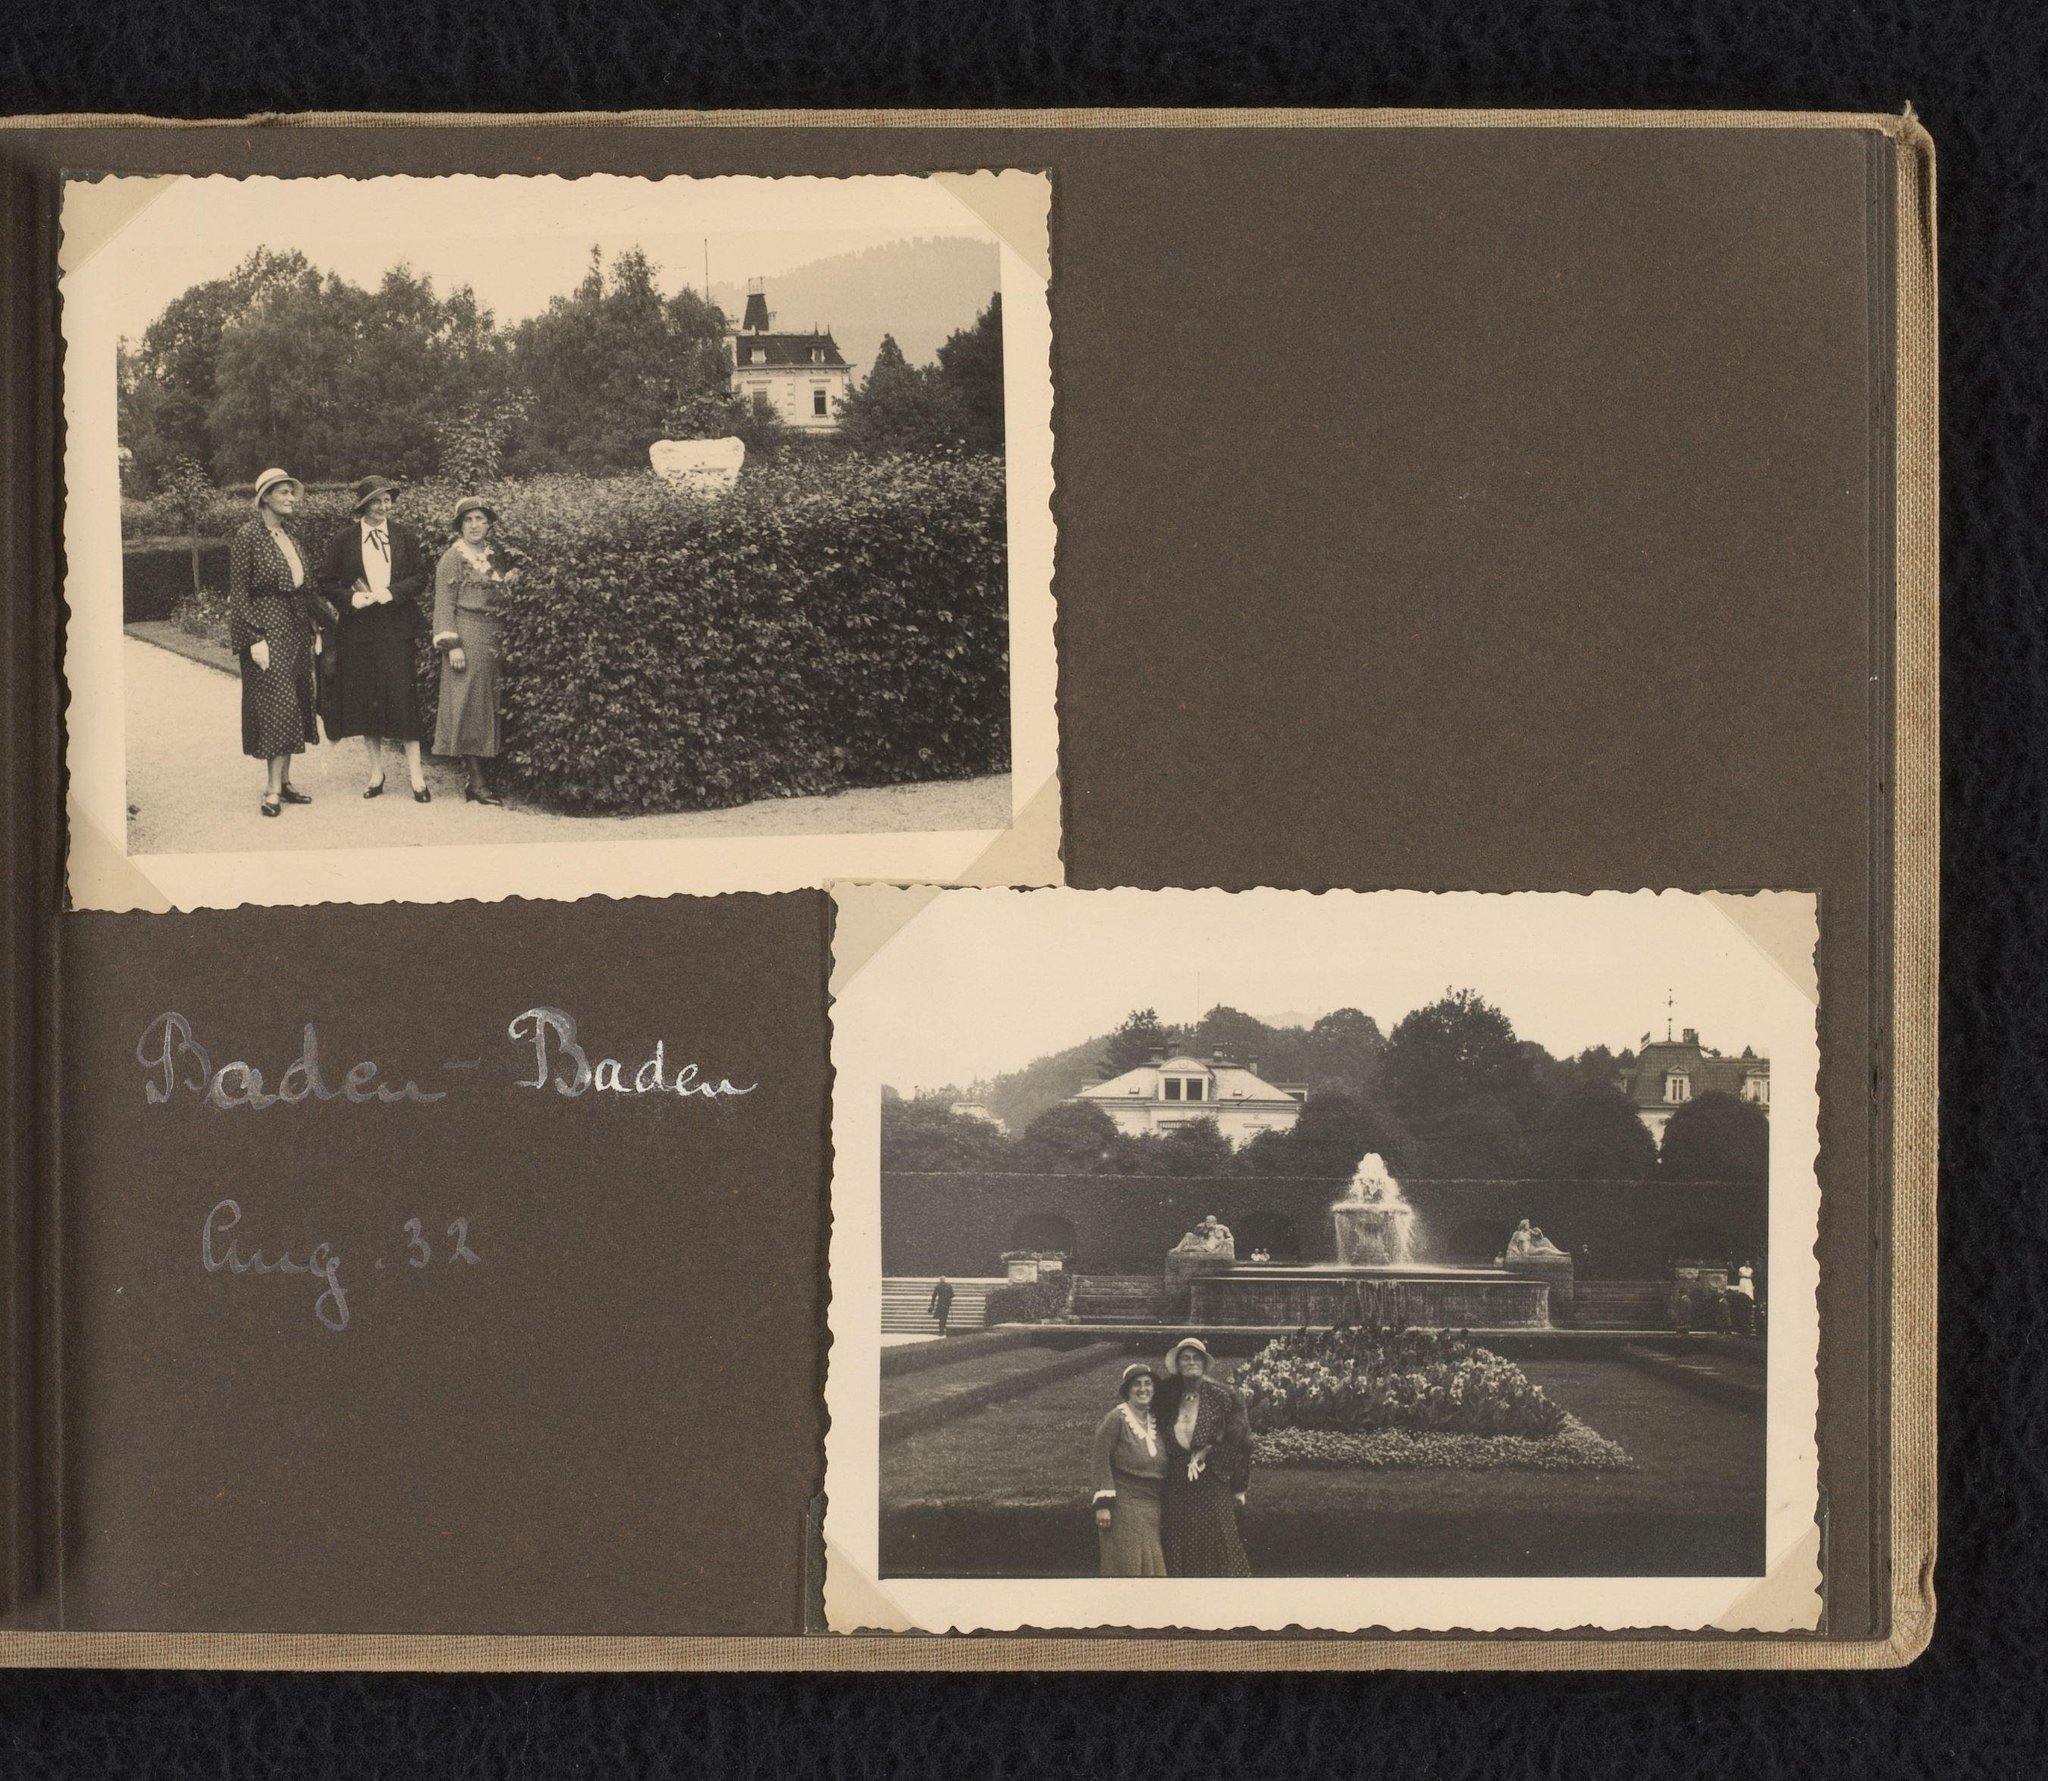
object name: photograph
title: Else Wachenheimer-Moos op vakantie met twee onbekende vrouwen, augustus 1932, Baden-Baden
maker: else wachenheimer-moos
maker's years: 1895-1944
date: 1908-1932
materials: cardboard, photographic support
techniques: gelatin silver print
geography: baden-baden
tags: else wachenheimer-moos, family life at home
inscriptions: date: ‘März 1932’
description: Blad bevat twee foto's. Alle foto's van Else Wachenheimer-Moos (lichte kraag) en twee onbekende vrouwen. Uit het album, half formaat, crèmekleurig stofomslag met koordbinding met banenmotief.